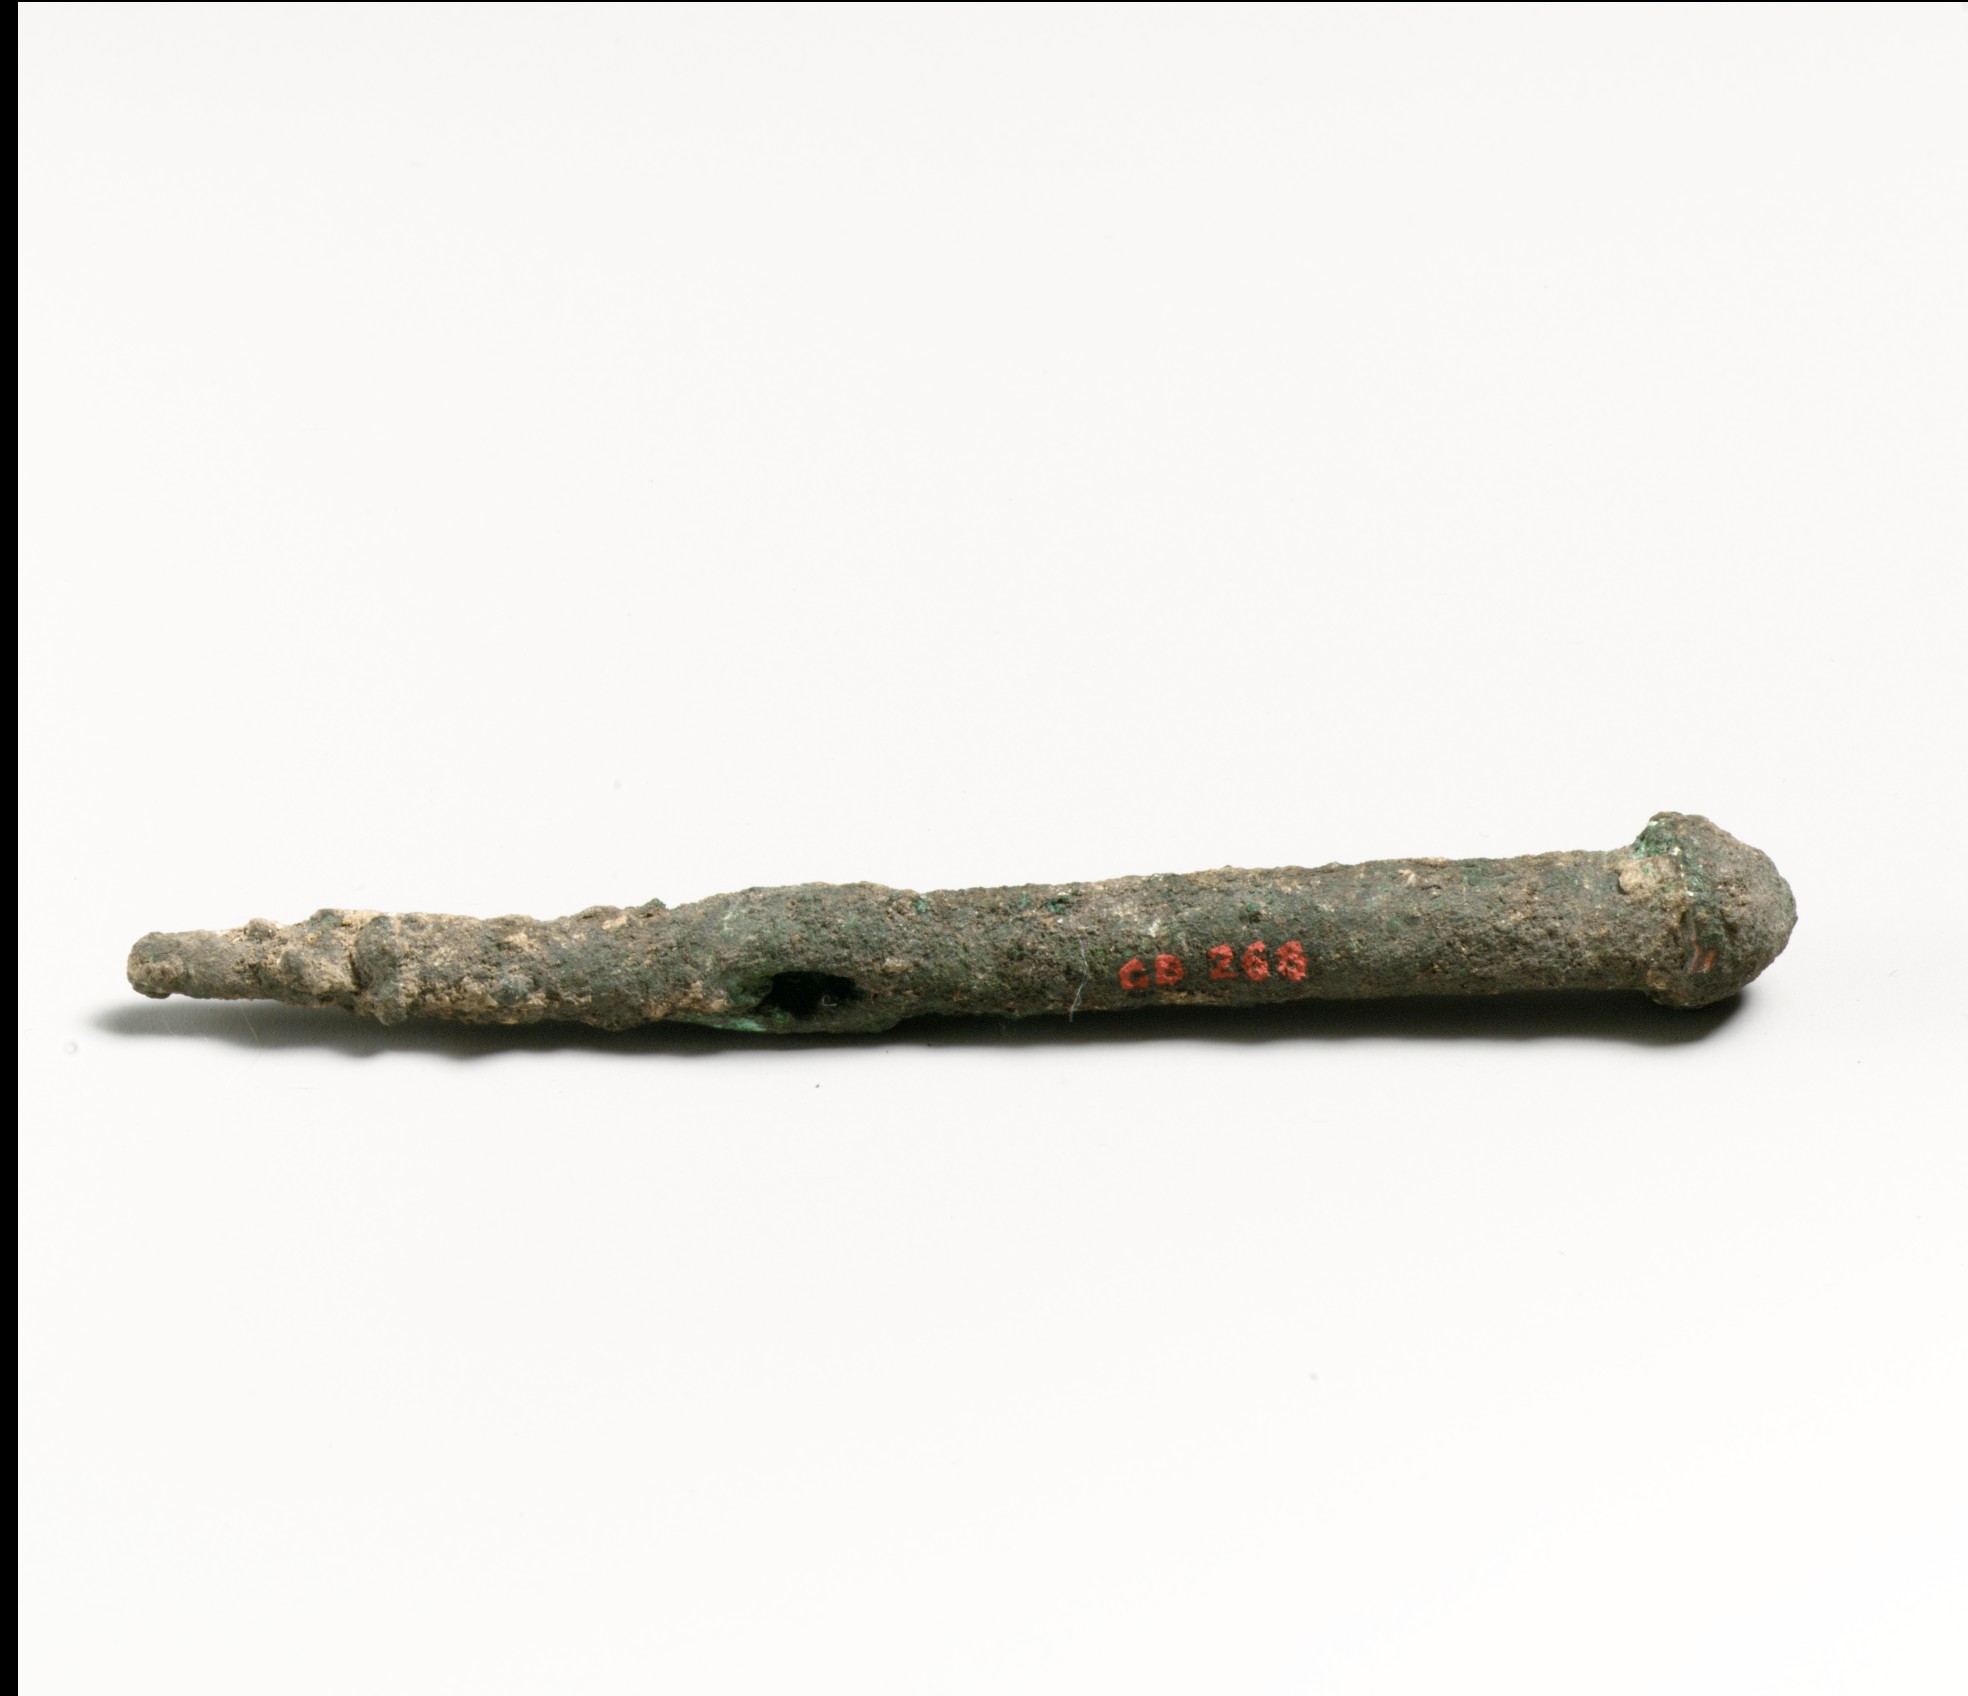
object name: pin, eyelet type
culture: cypriot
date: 3900 BCE-100 CE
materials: bronze